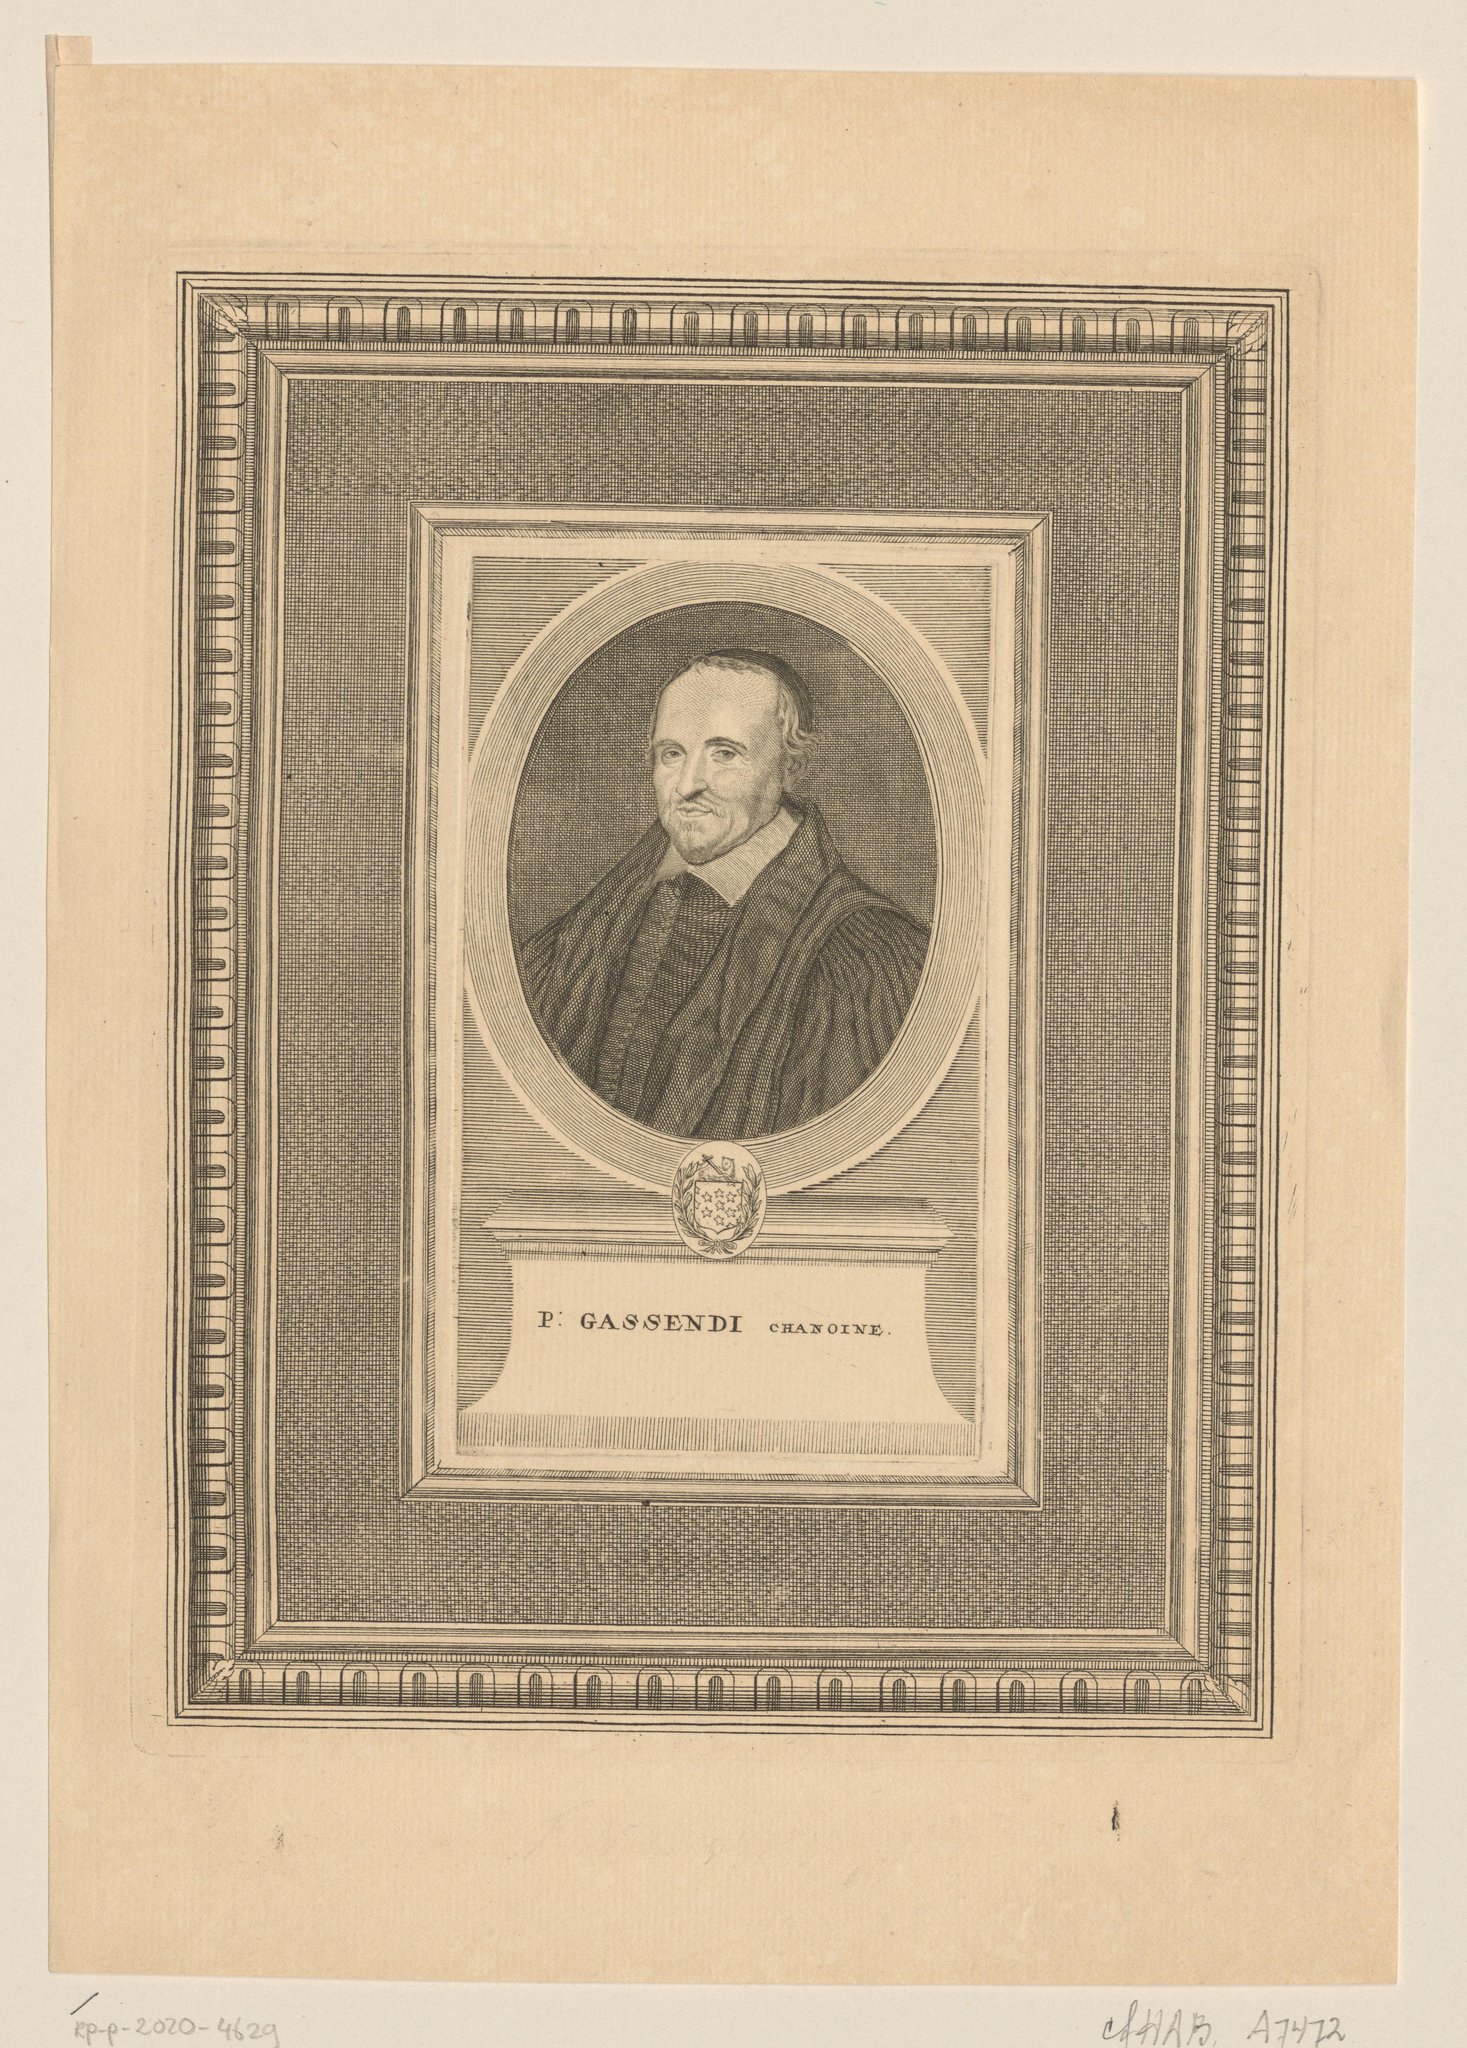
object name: print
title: Portret van Pierre Gassendi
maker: Anonymous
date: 1634-1700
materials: paper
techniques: engraving, etching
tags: paris, priest, historical persons, scholar, philosopher (+ portrait of scholar, scientist)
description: Omkadering gedrukt van een aparte plaat.